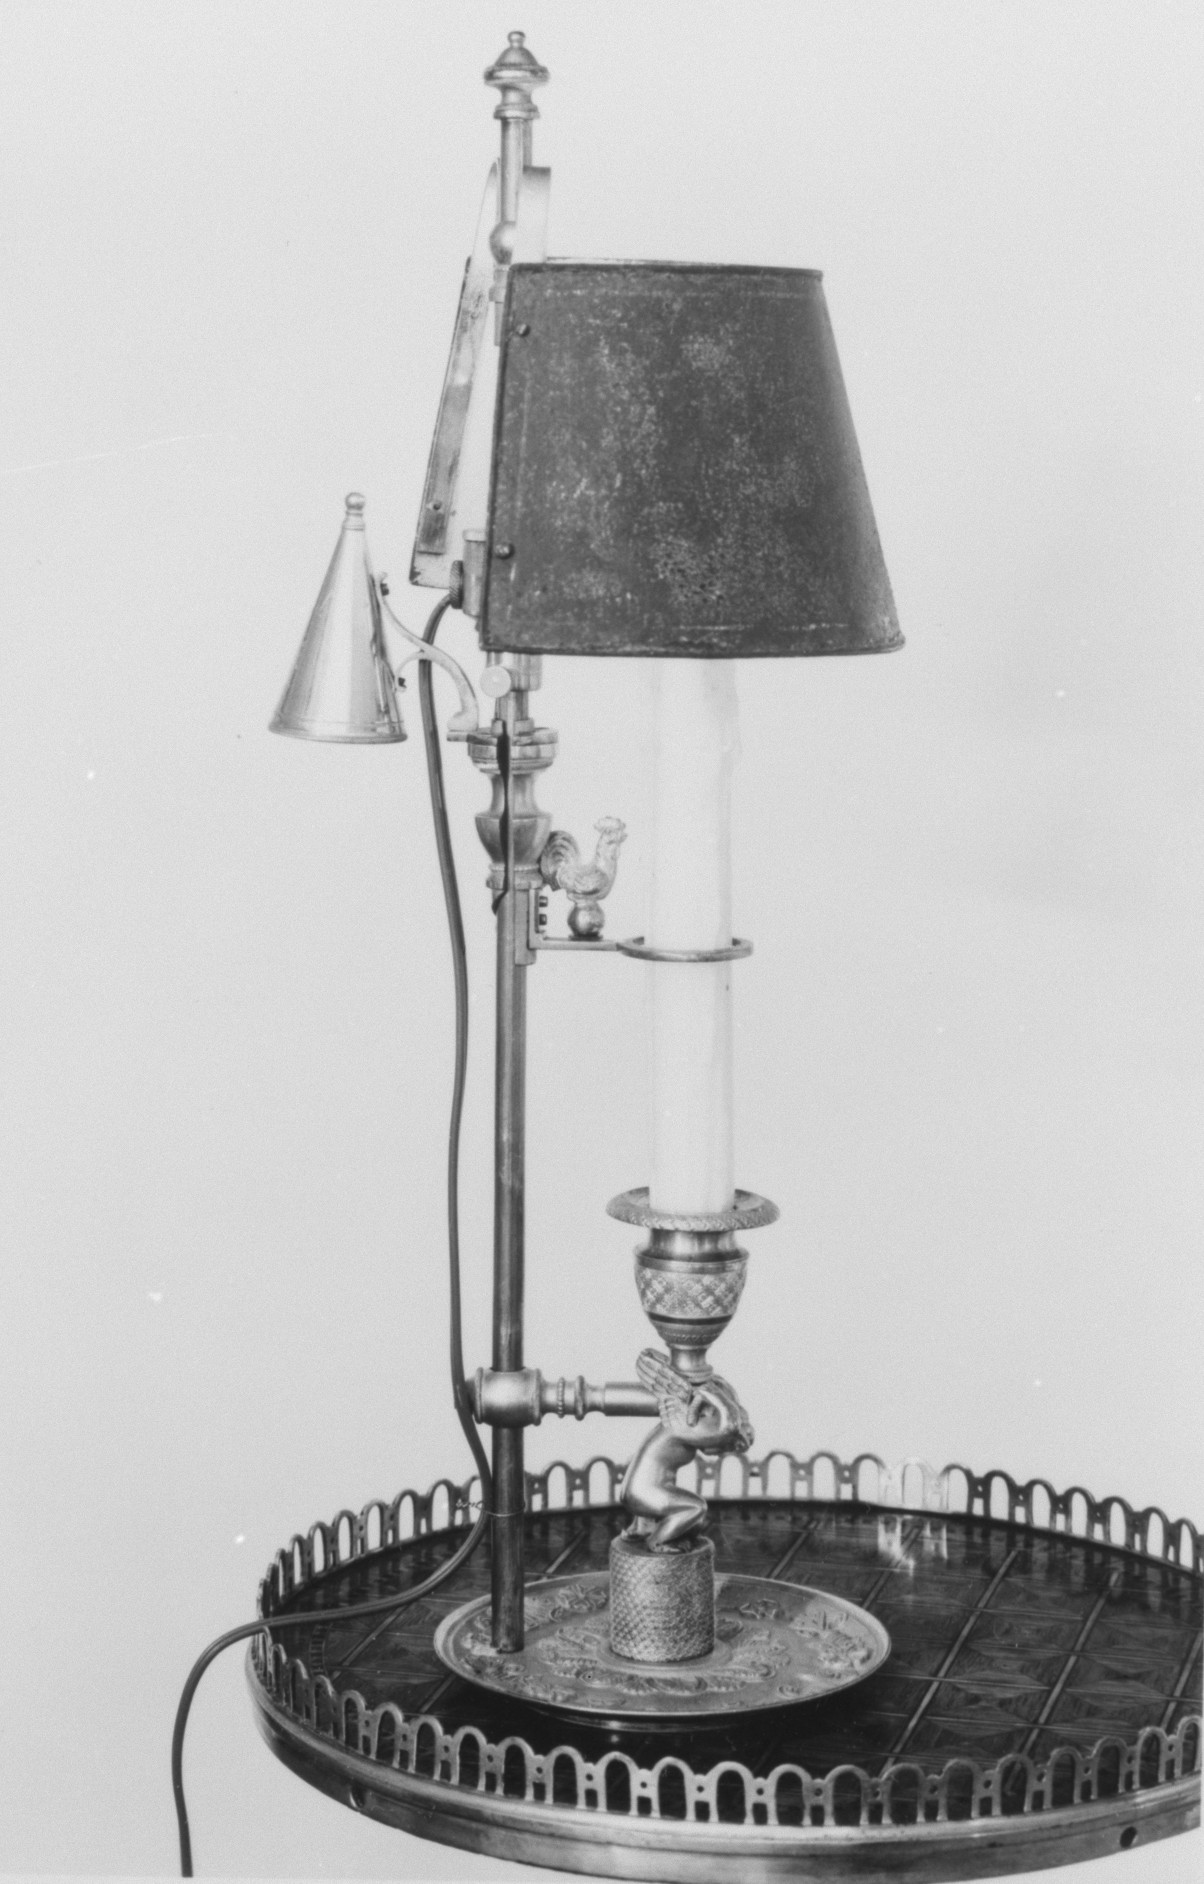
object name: candlestick and shade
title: Candlestick with shade (flambeau à écran)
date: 1801-1825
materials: brass, gilt bronze, steel